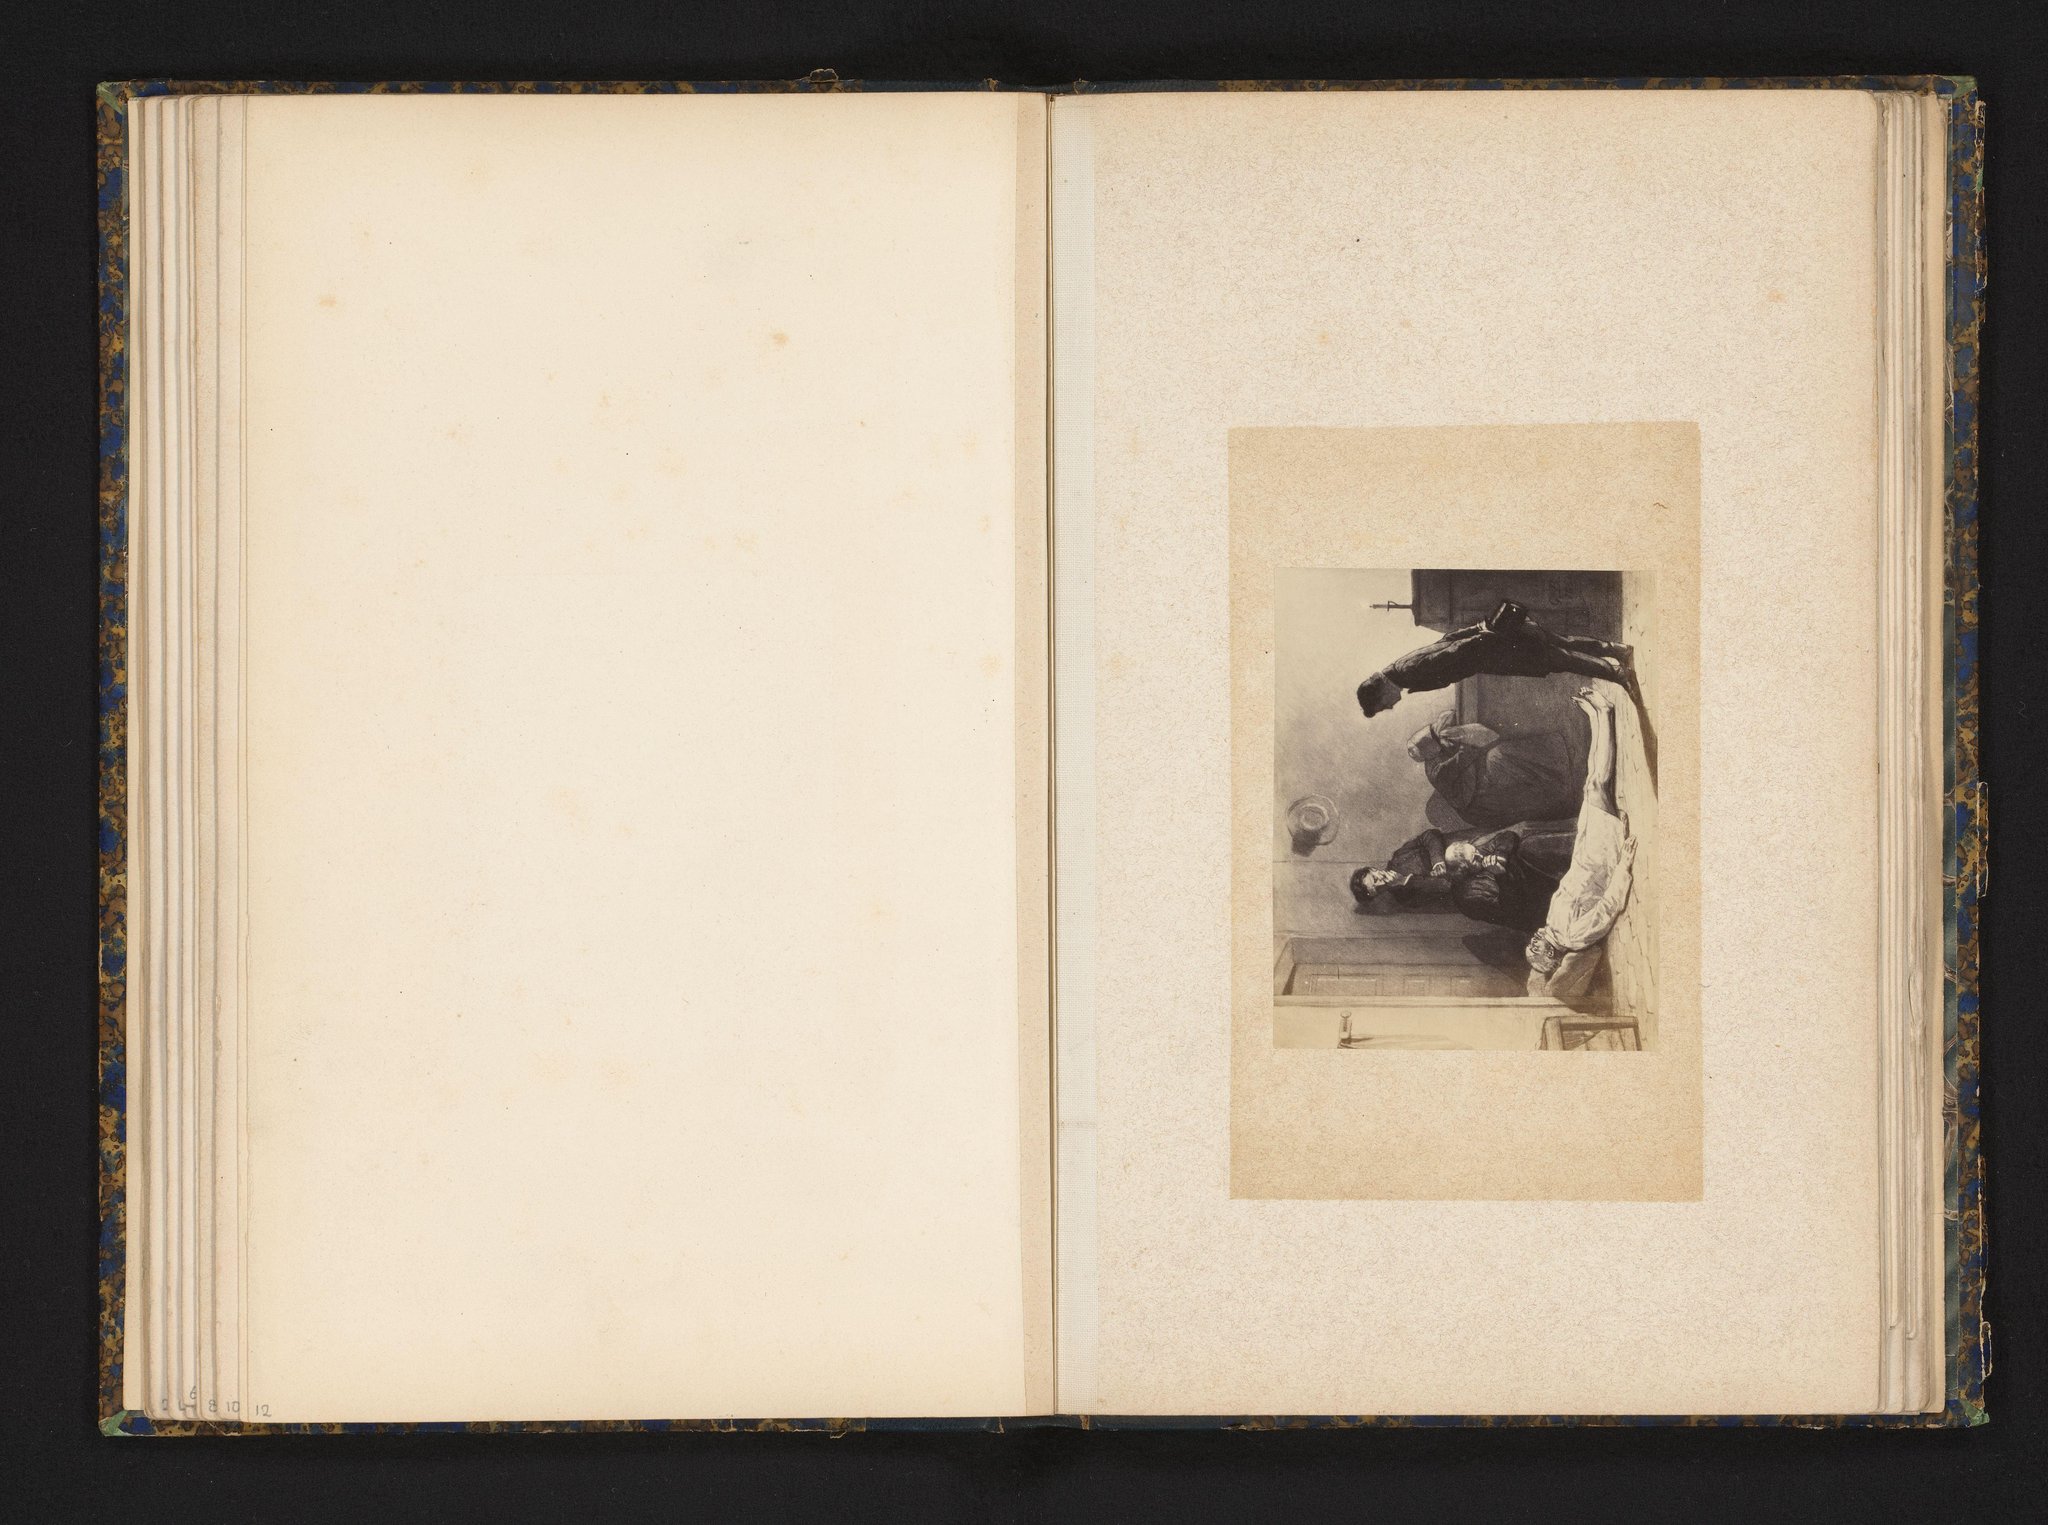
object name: reproduction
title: Fotoreproductie van een tekening van de dood van kolonel Pontmercy uit Les Misérables van Victor Hugo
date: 1862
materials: photographic support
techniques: albumen print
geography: paris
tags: specific works of literature